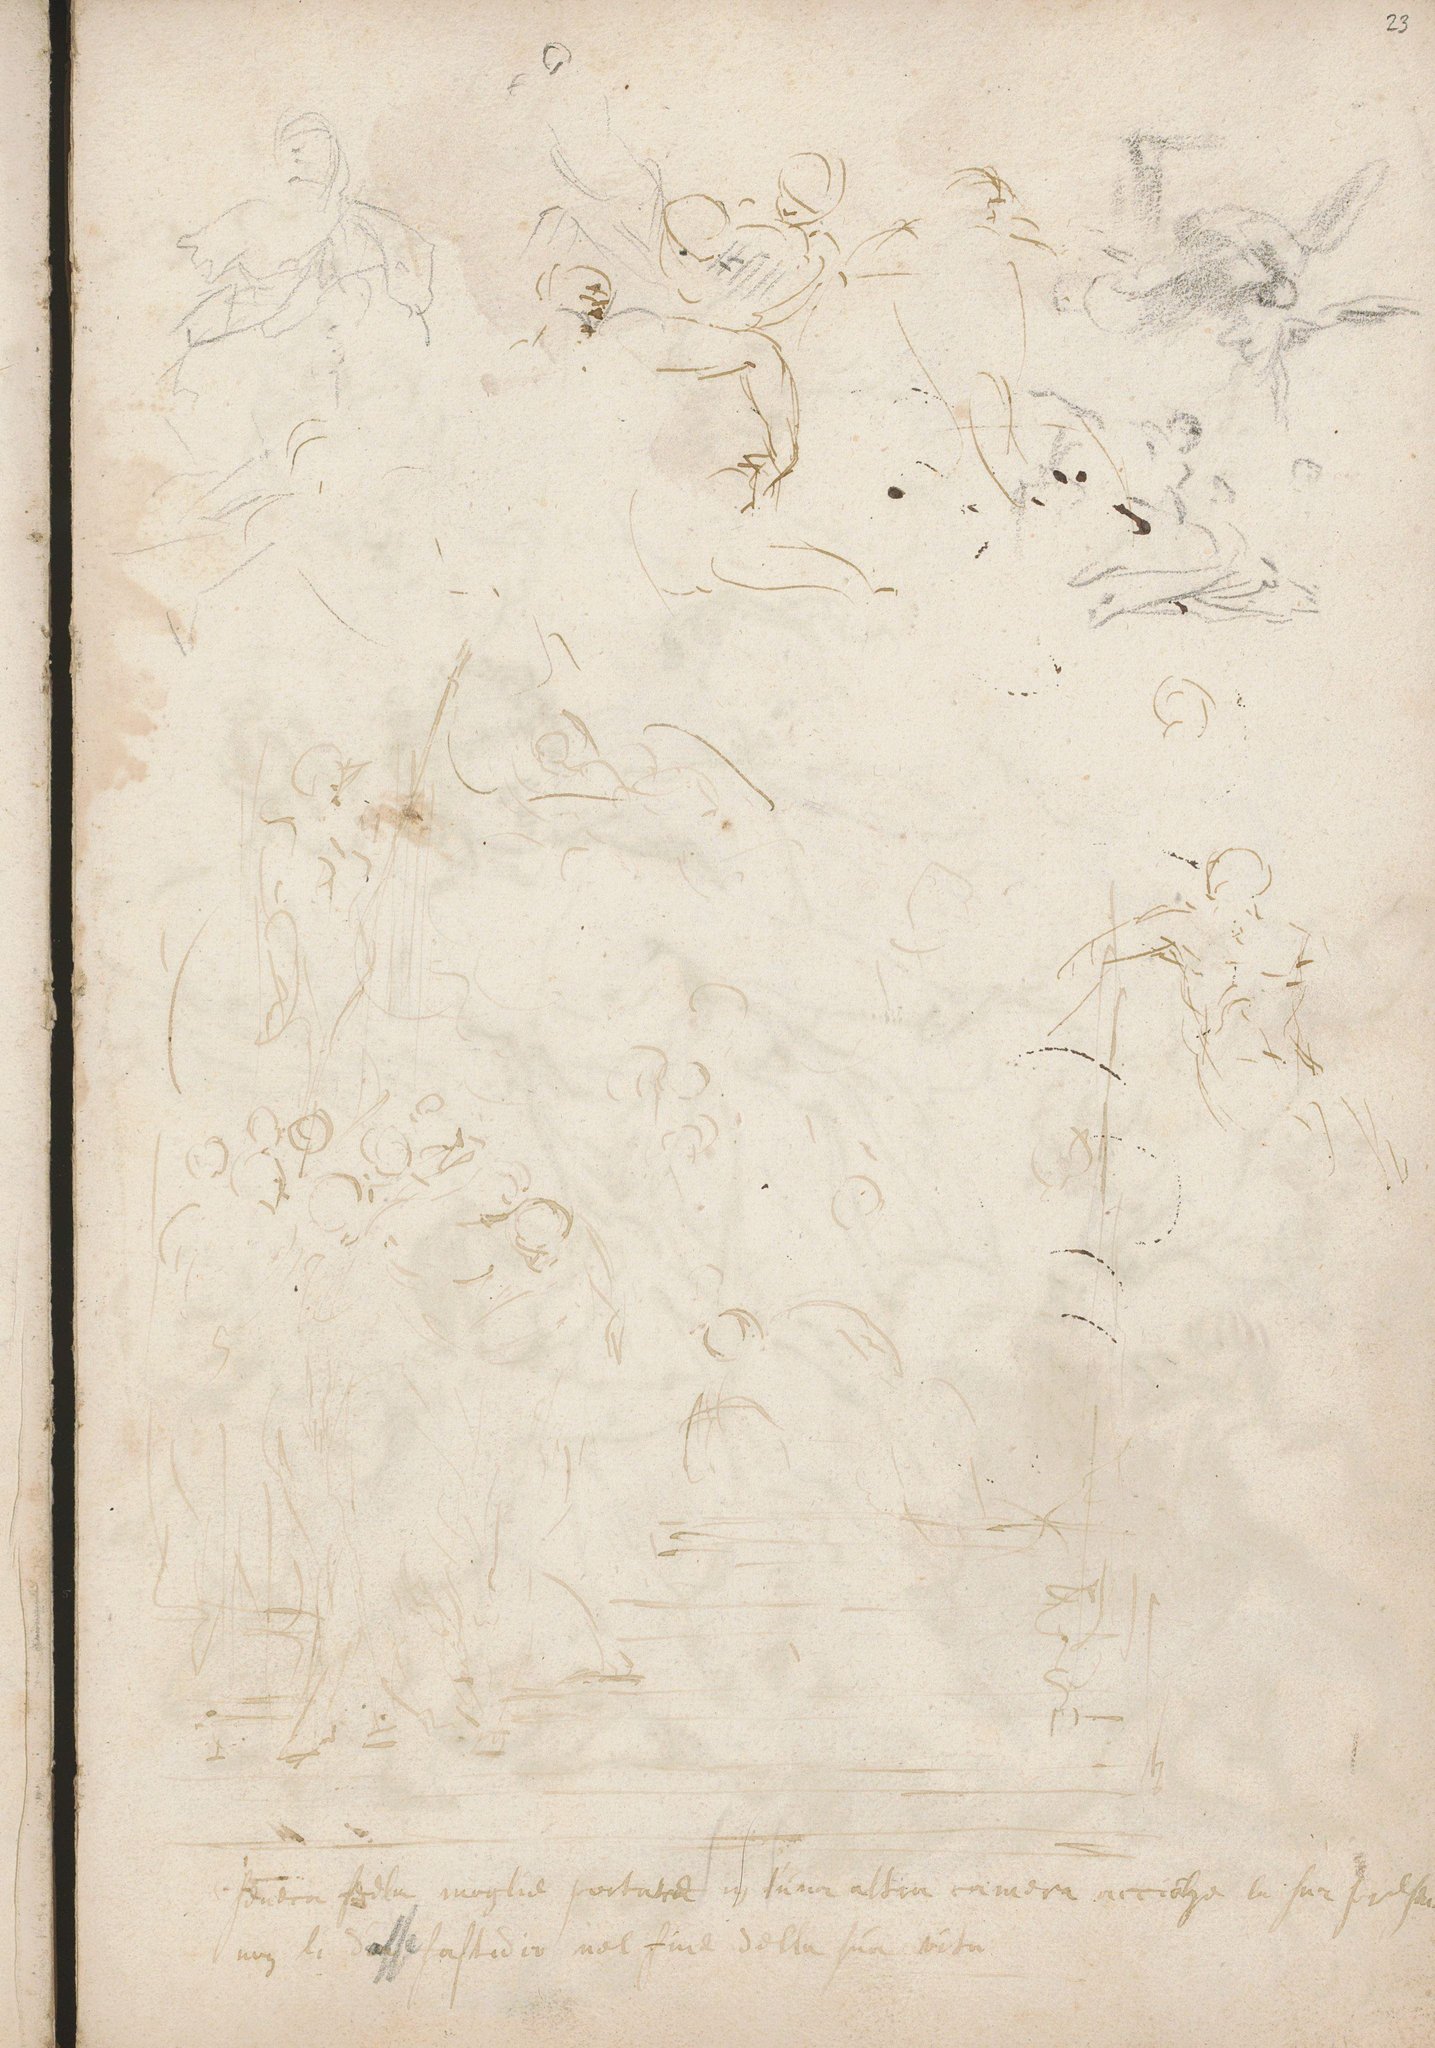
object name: sketchbook leaf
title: Compositiestudie en figuren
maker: Anonymous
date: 1650-1799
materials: ink, paper, pencil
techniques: pen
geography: italy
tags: anatomy (non-medical)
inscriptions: annotation: ‘[...] moglie porta[...] ... sol[...] píu vita’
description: Bladzijde 23 uit een schetsboek met 72 bladzijden.